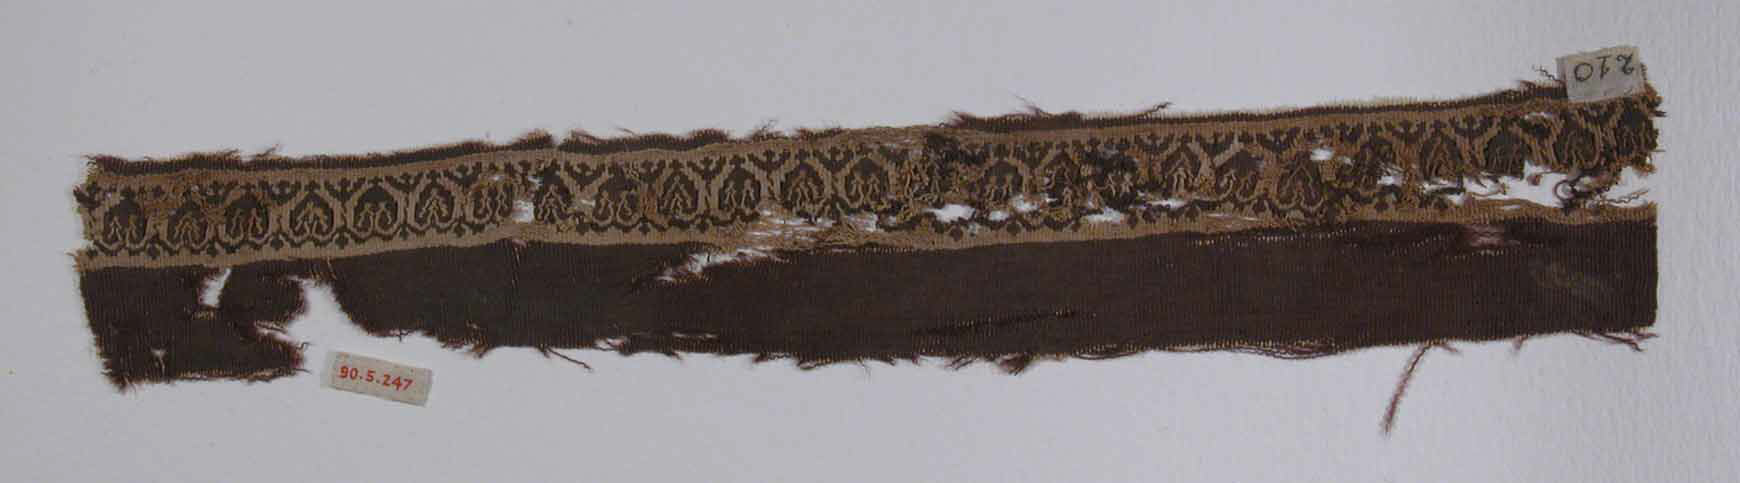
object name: textile fragment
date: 401-500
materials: linen, wool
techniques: weave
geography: egypt